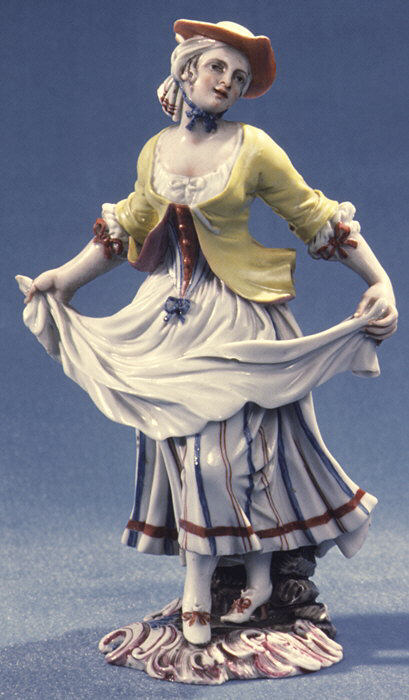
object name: figure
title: Dancing girl (Columbine)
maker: doccia porcelain manufactory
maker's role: manufactory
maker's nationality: italian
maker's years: 1737-1896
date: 1770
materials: soft paste porcelain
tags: girls,dancing